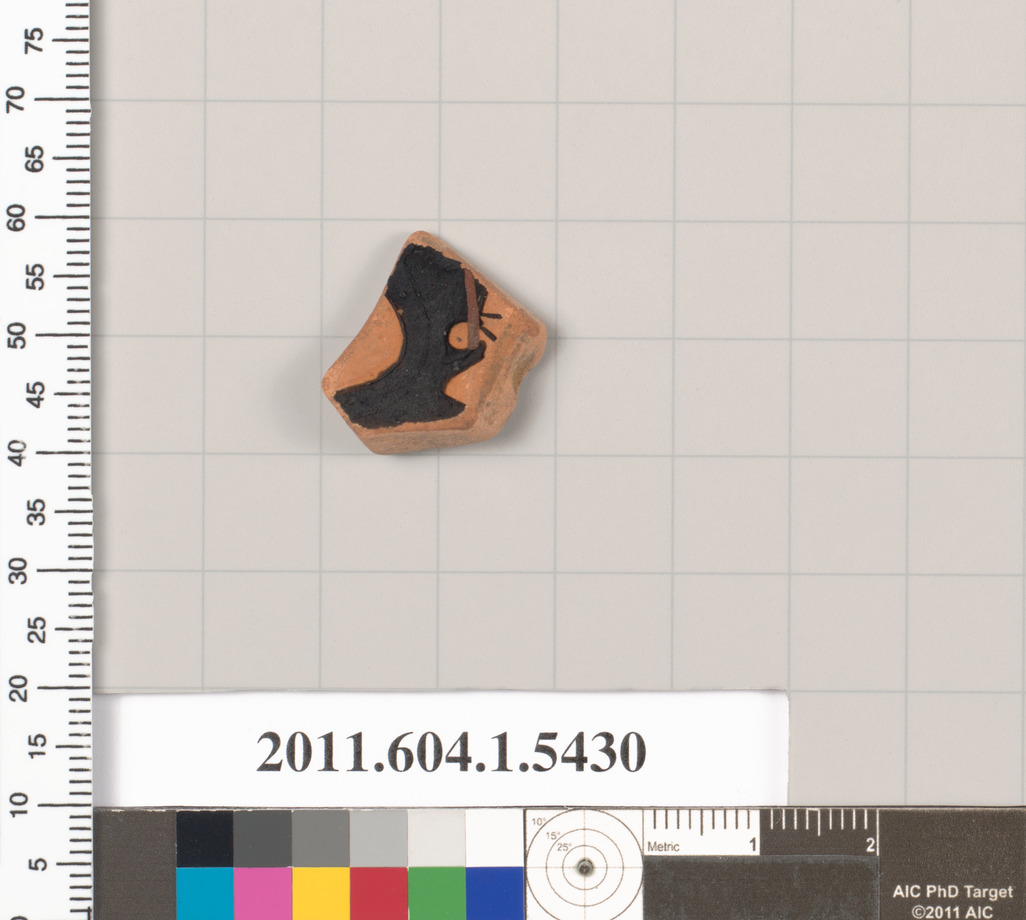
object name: kylix fragment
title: Terracotta fragment of a kylix (drinking cup)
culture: greek, attic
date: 500-480 BCE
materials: terracotta